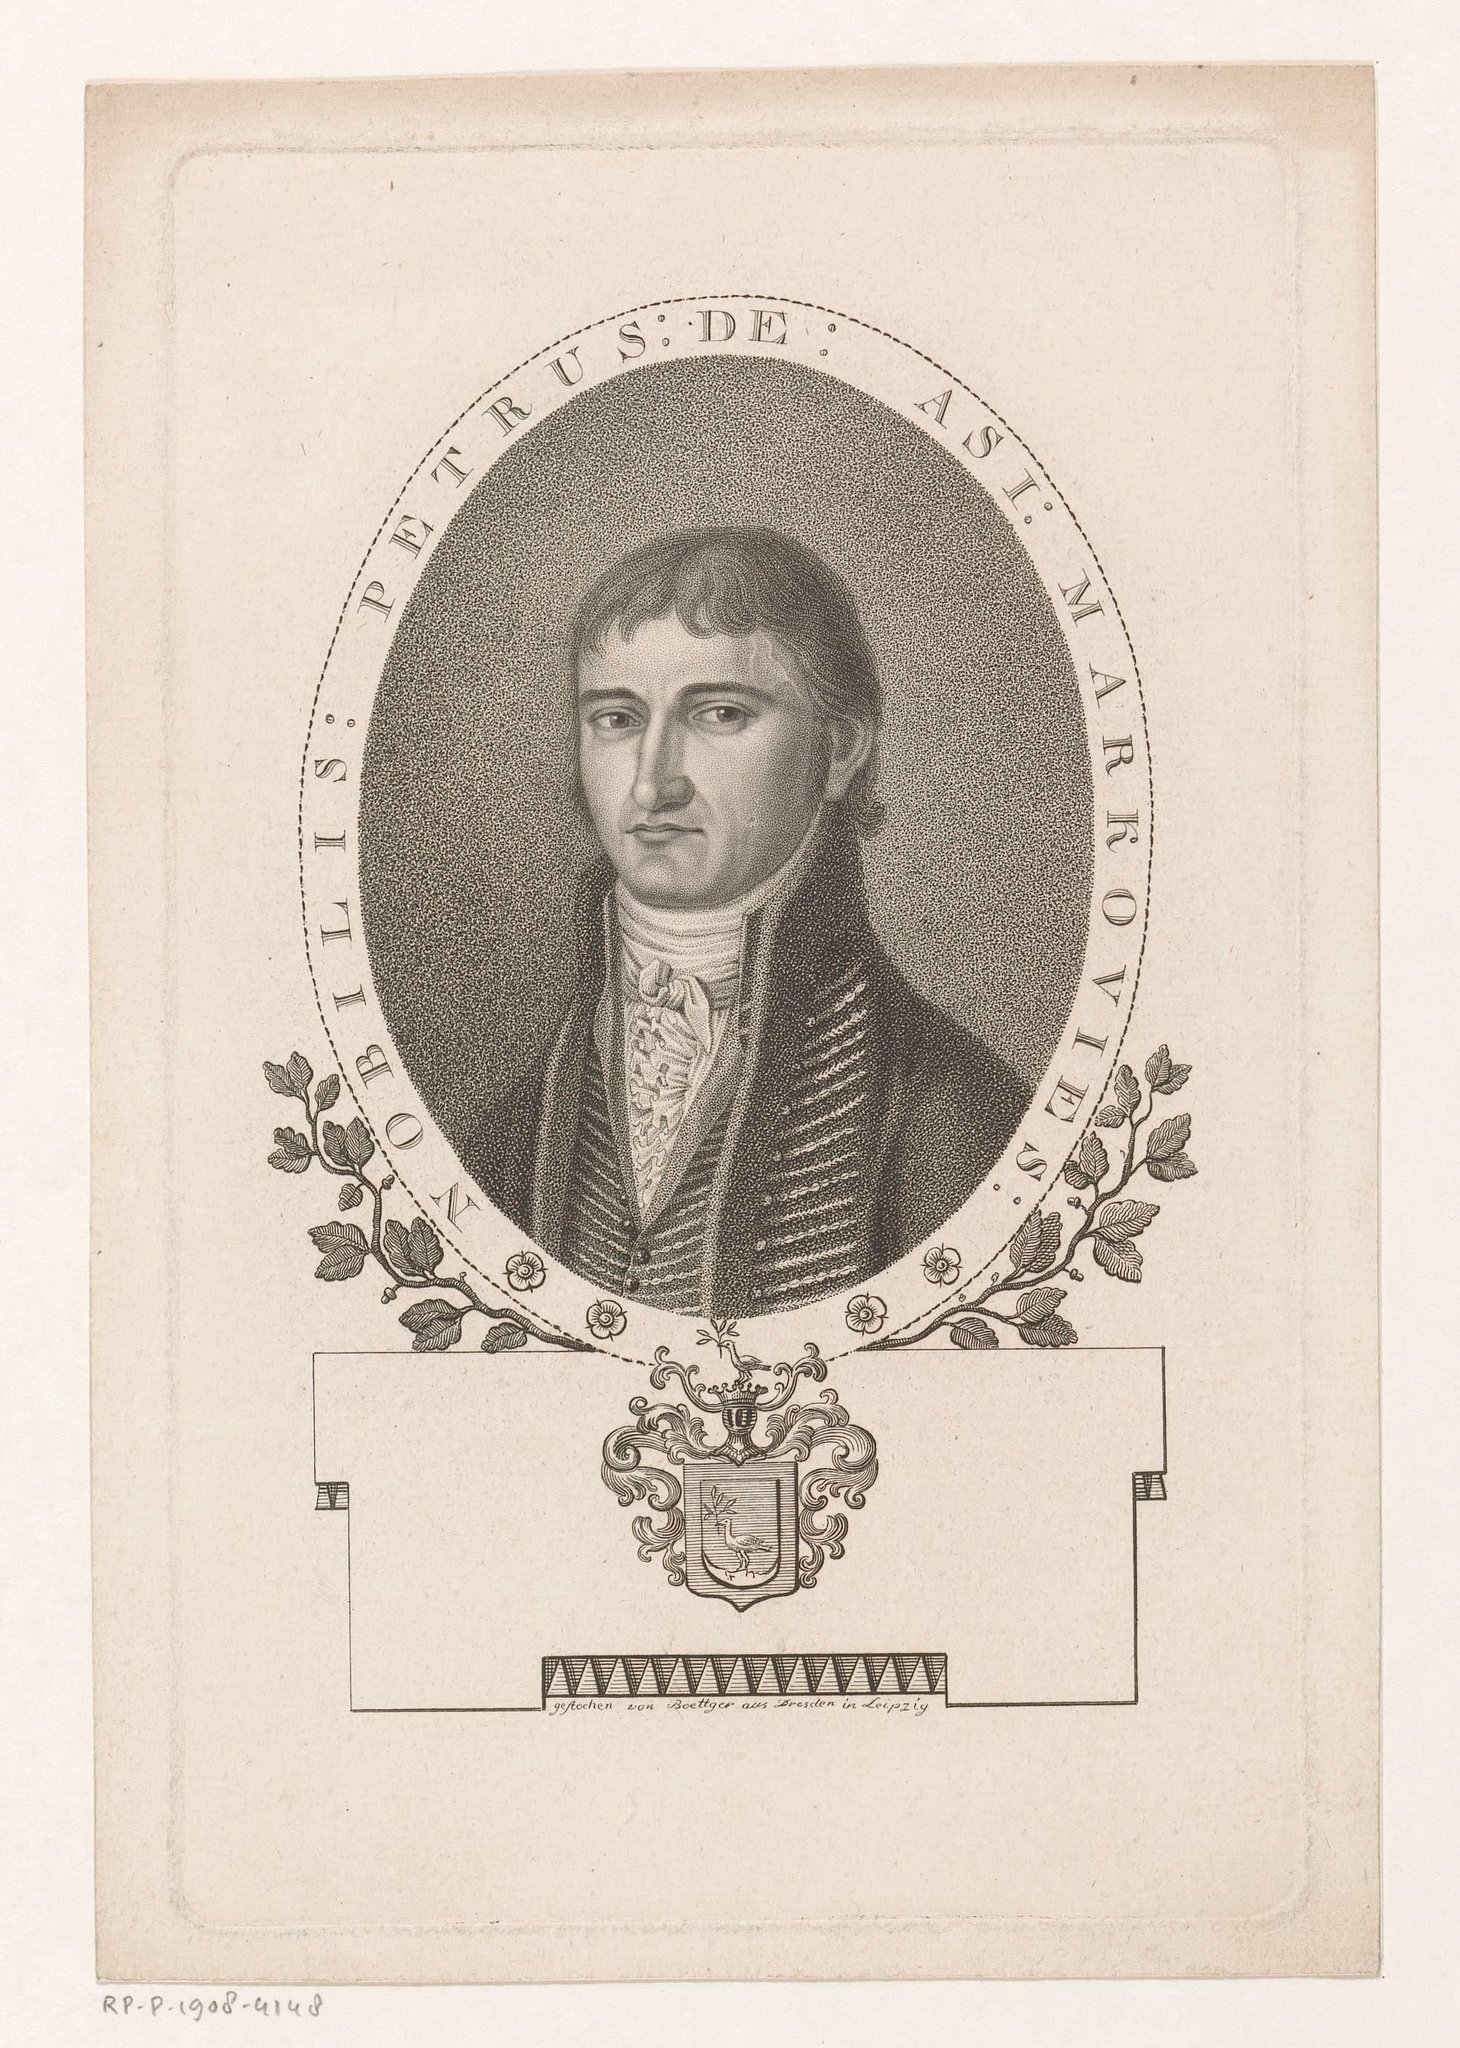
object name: print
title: Portret van Péter Asi-Markovics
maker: johann gottlieb boettger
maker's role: print maker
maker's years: 1763-1825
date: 1796-1825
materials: paper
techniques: etching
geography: leipzig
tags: historical persons, armorial bearing, heraldry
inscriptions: collector's mark: Lugt 2228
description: Waarschijnlijk is op dit portret de Hongaarse schrijver Péter Asi-Markovics afgebeeld (1770-1844).